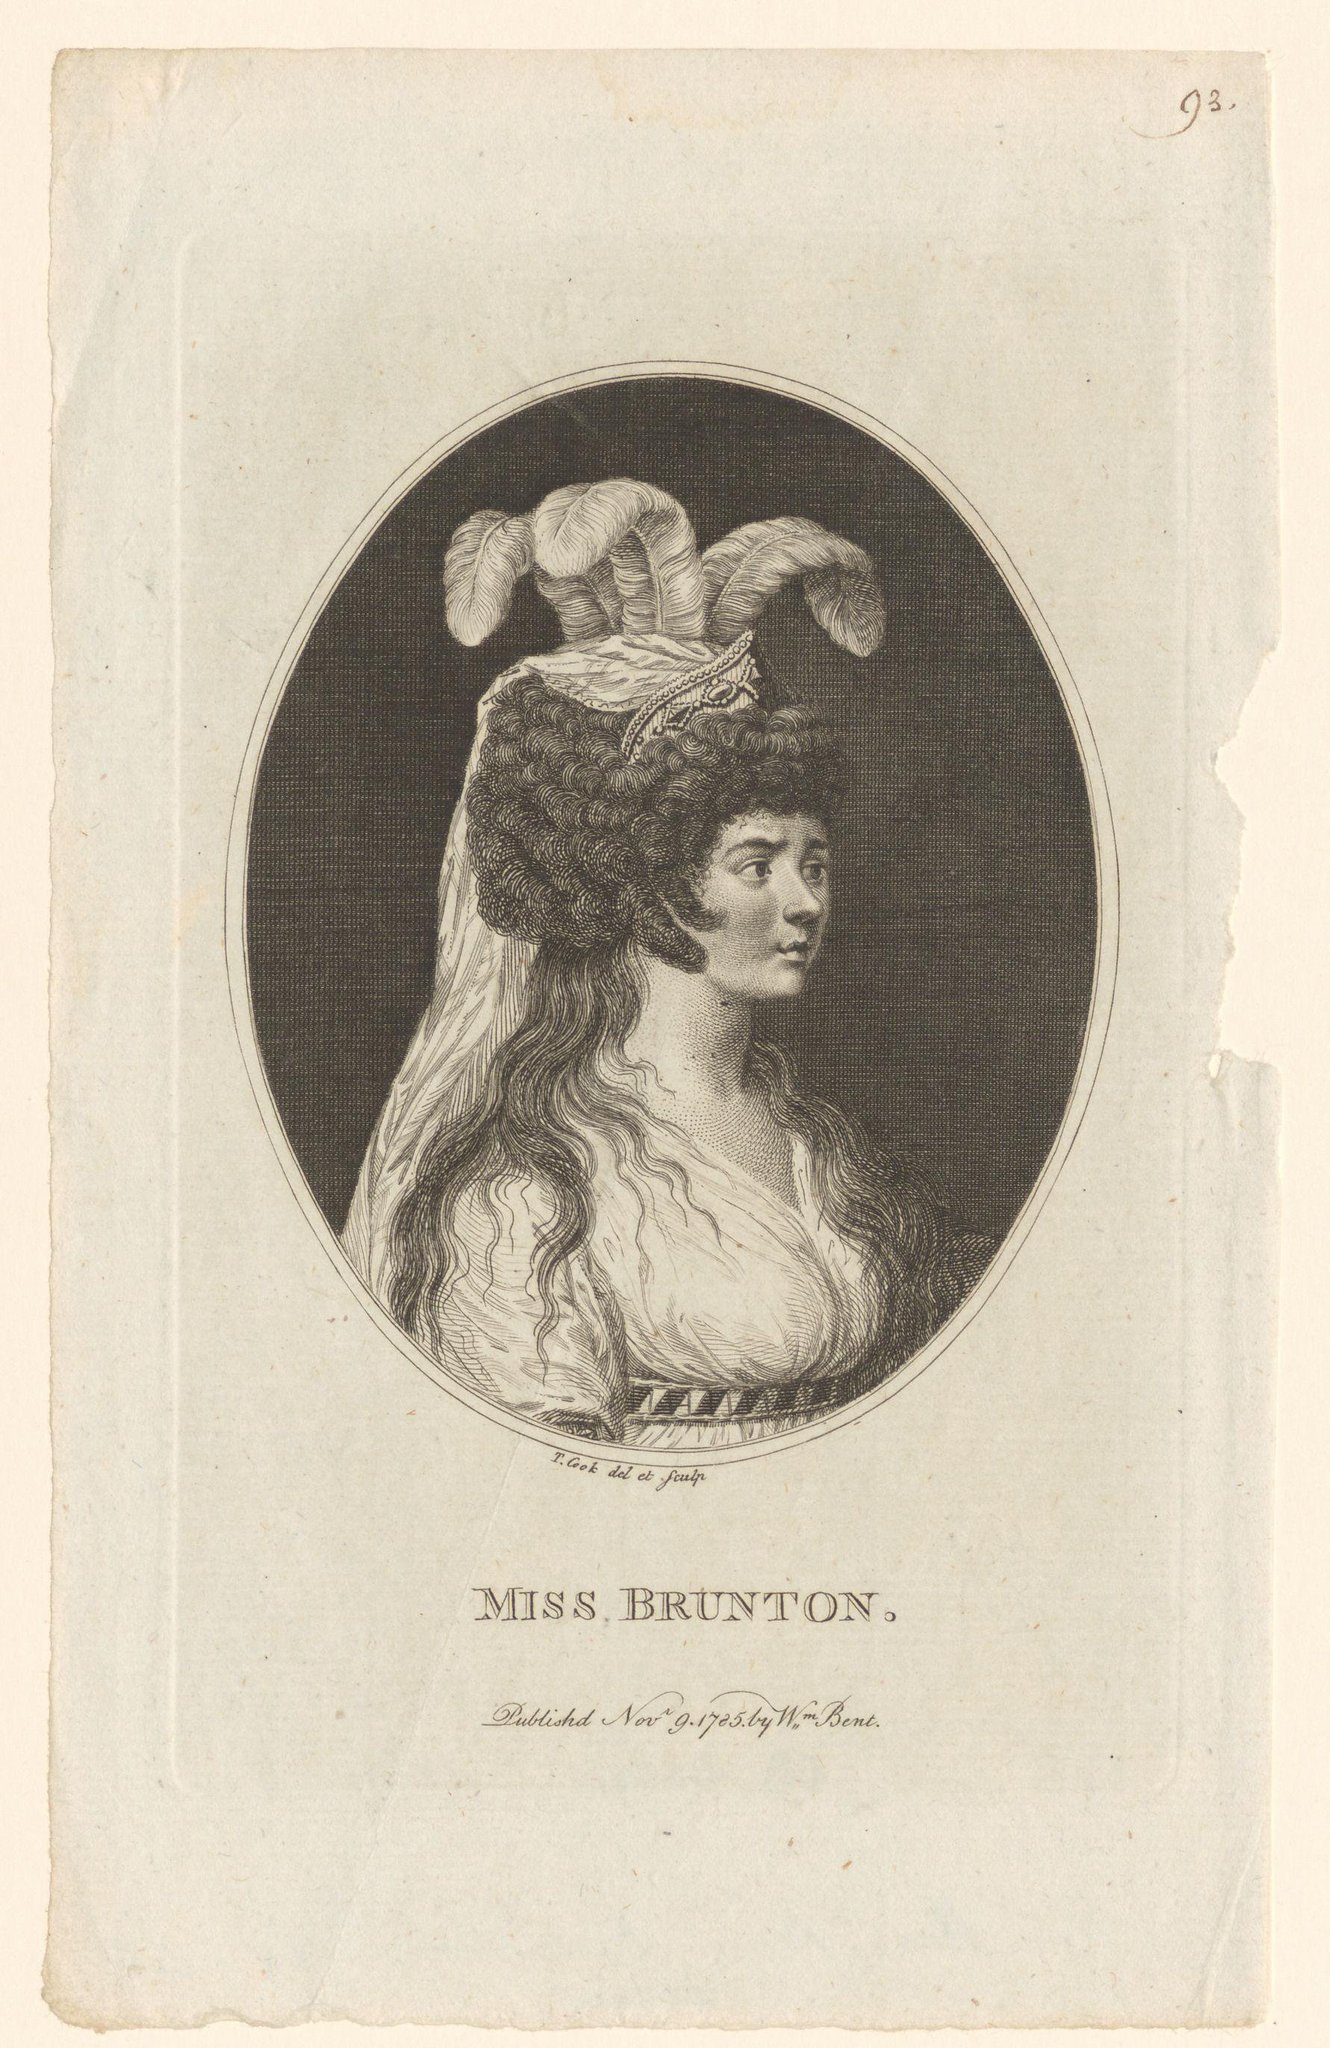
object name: print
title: Portret van Ann Brunton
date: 1785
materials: paper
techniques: engraving, etching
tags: historical persons, portrait of actor, actress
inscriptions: number: ‘93’, collector's mark: Lugt 2228